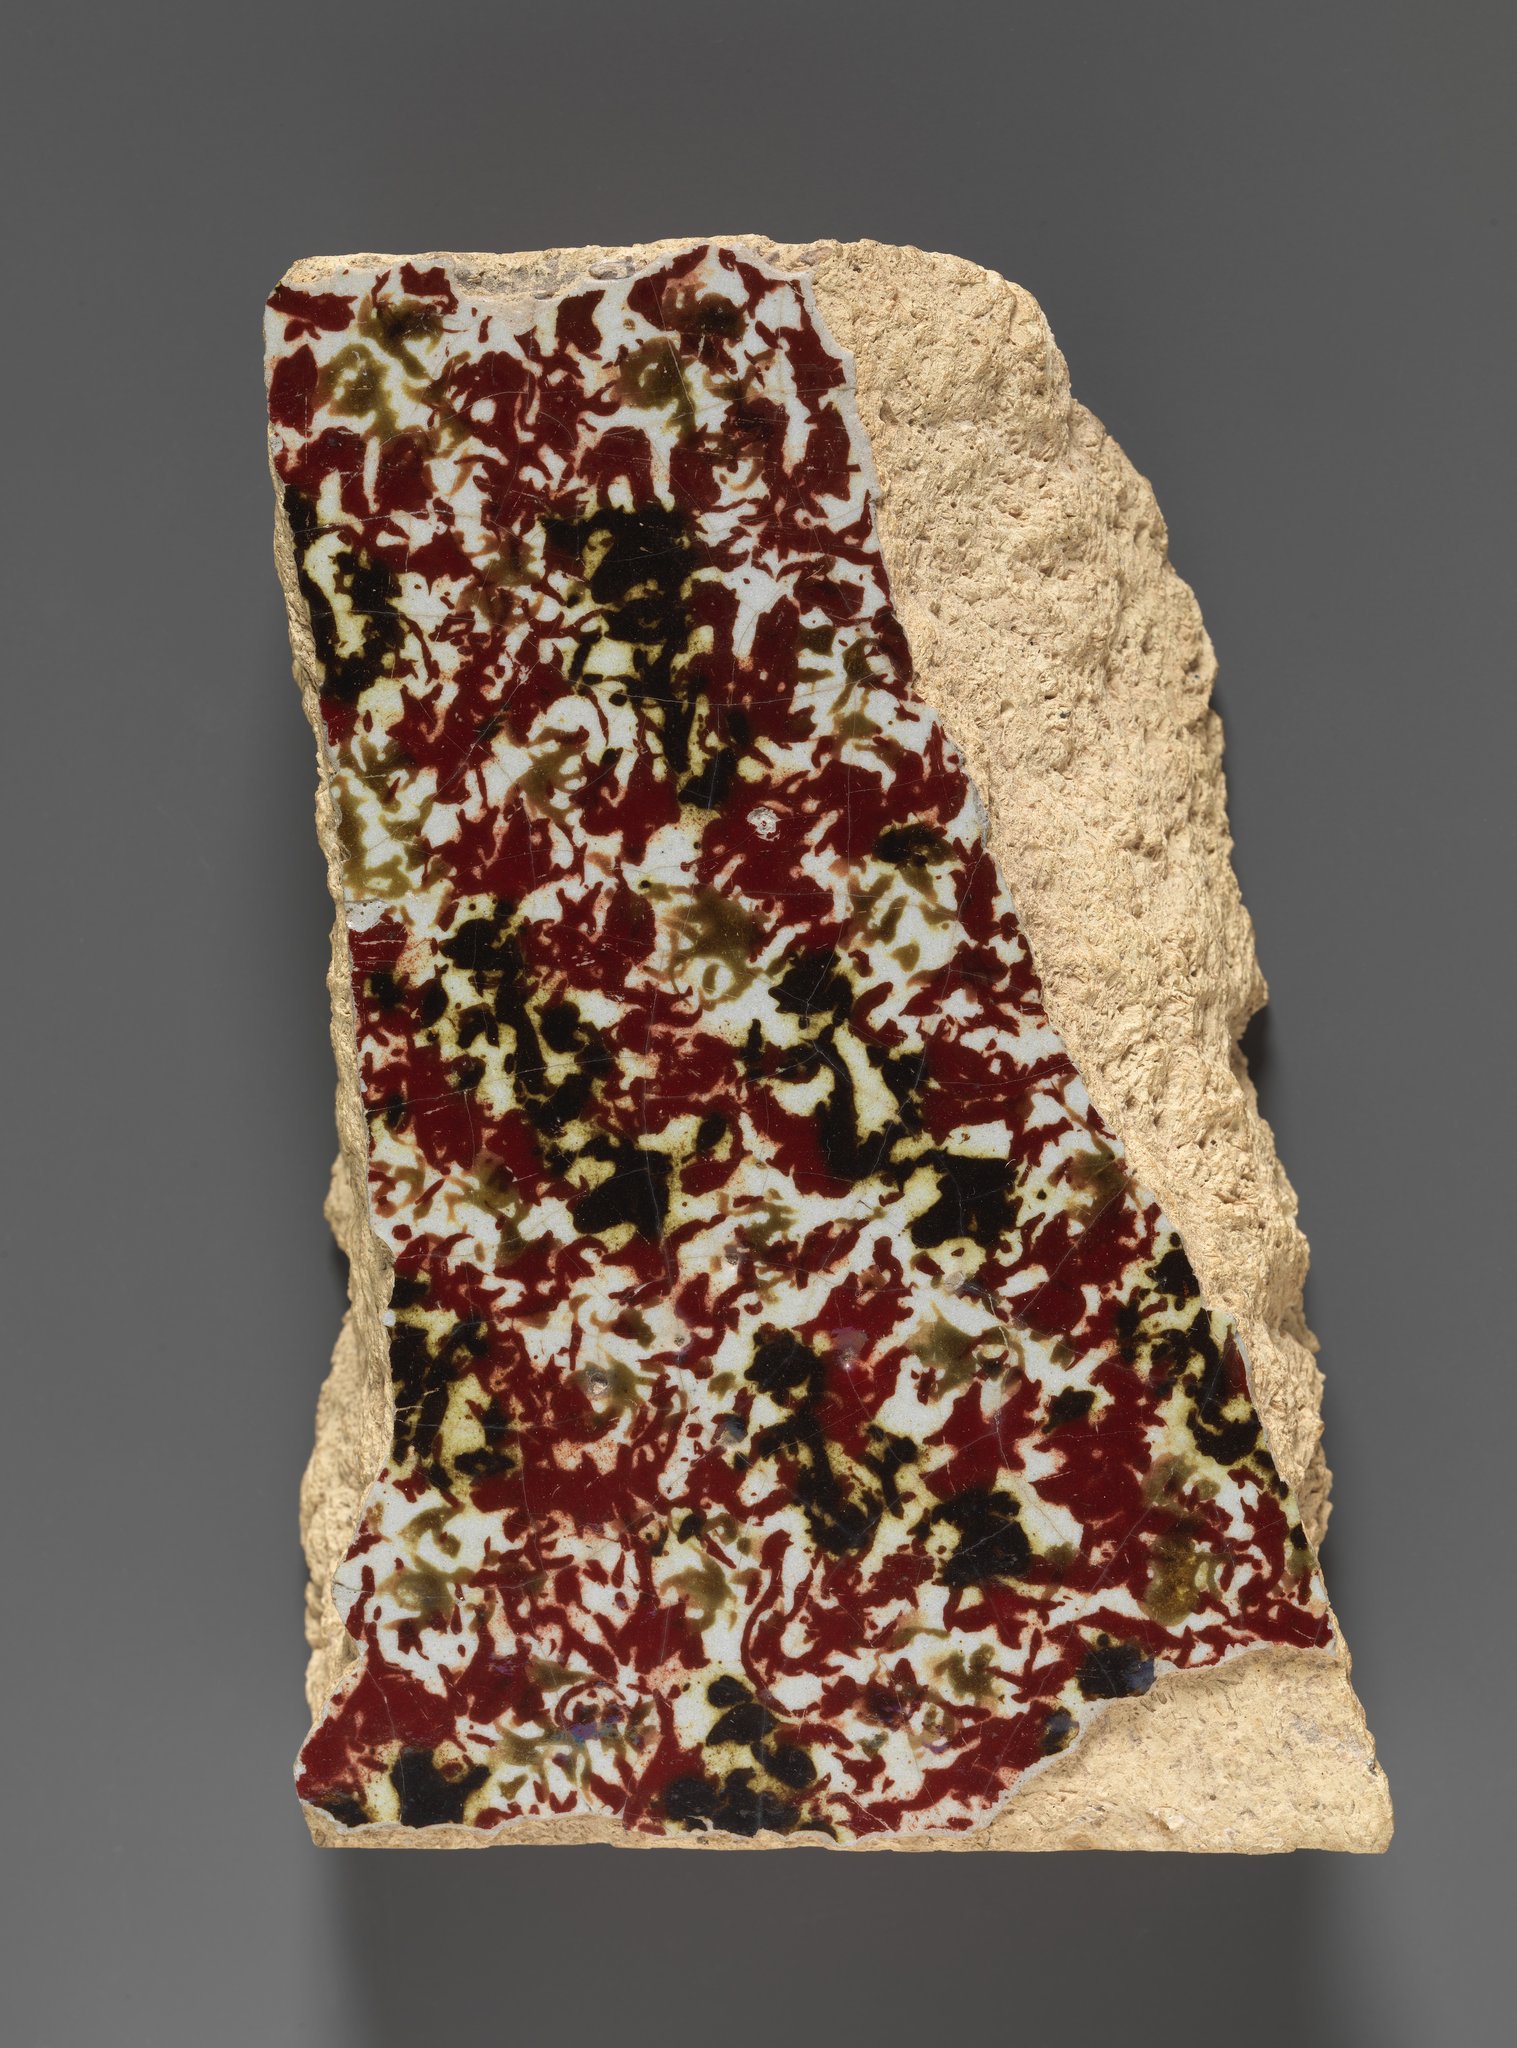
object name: tile fragment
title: Polychrome Luster Tile Fragment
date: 801-900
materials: earthenware, glaze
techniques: luster painting, polychrome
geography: iraq